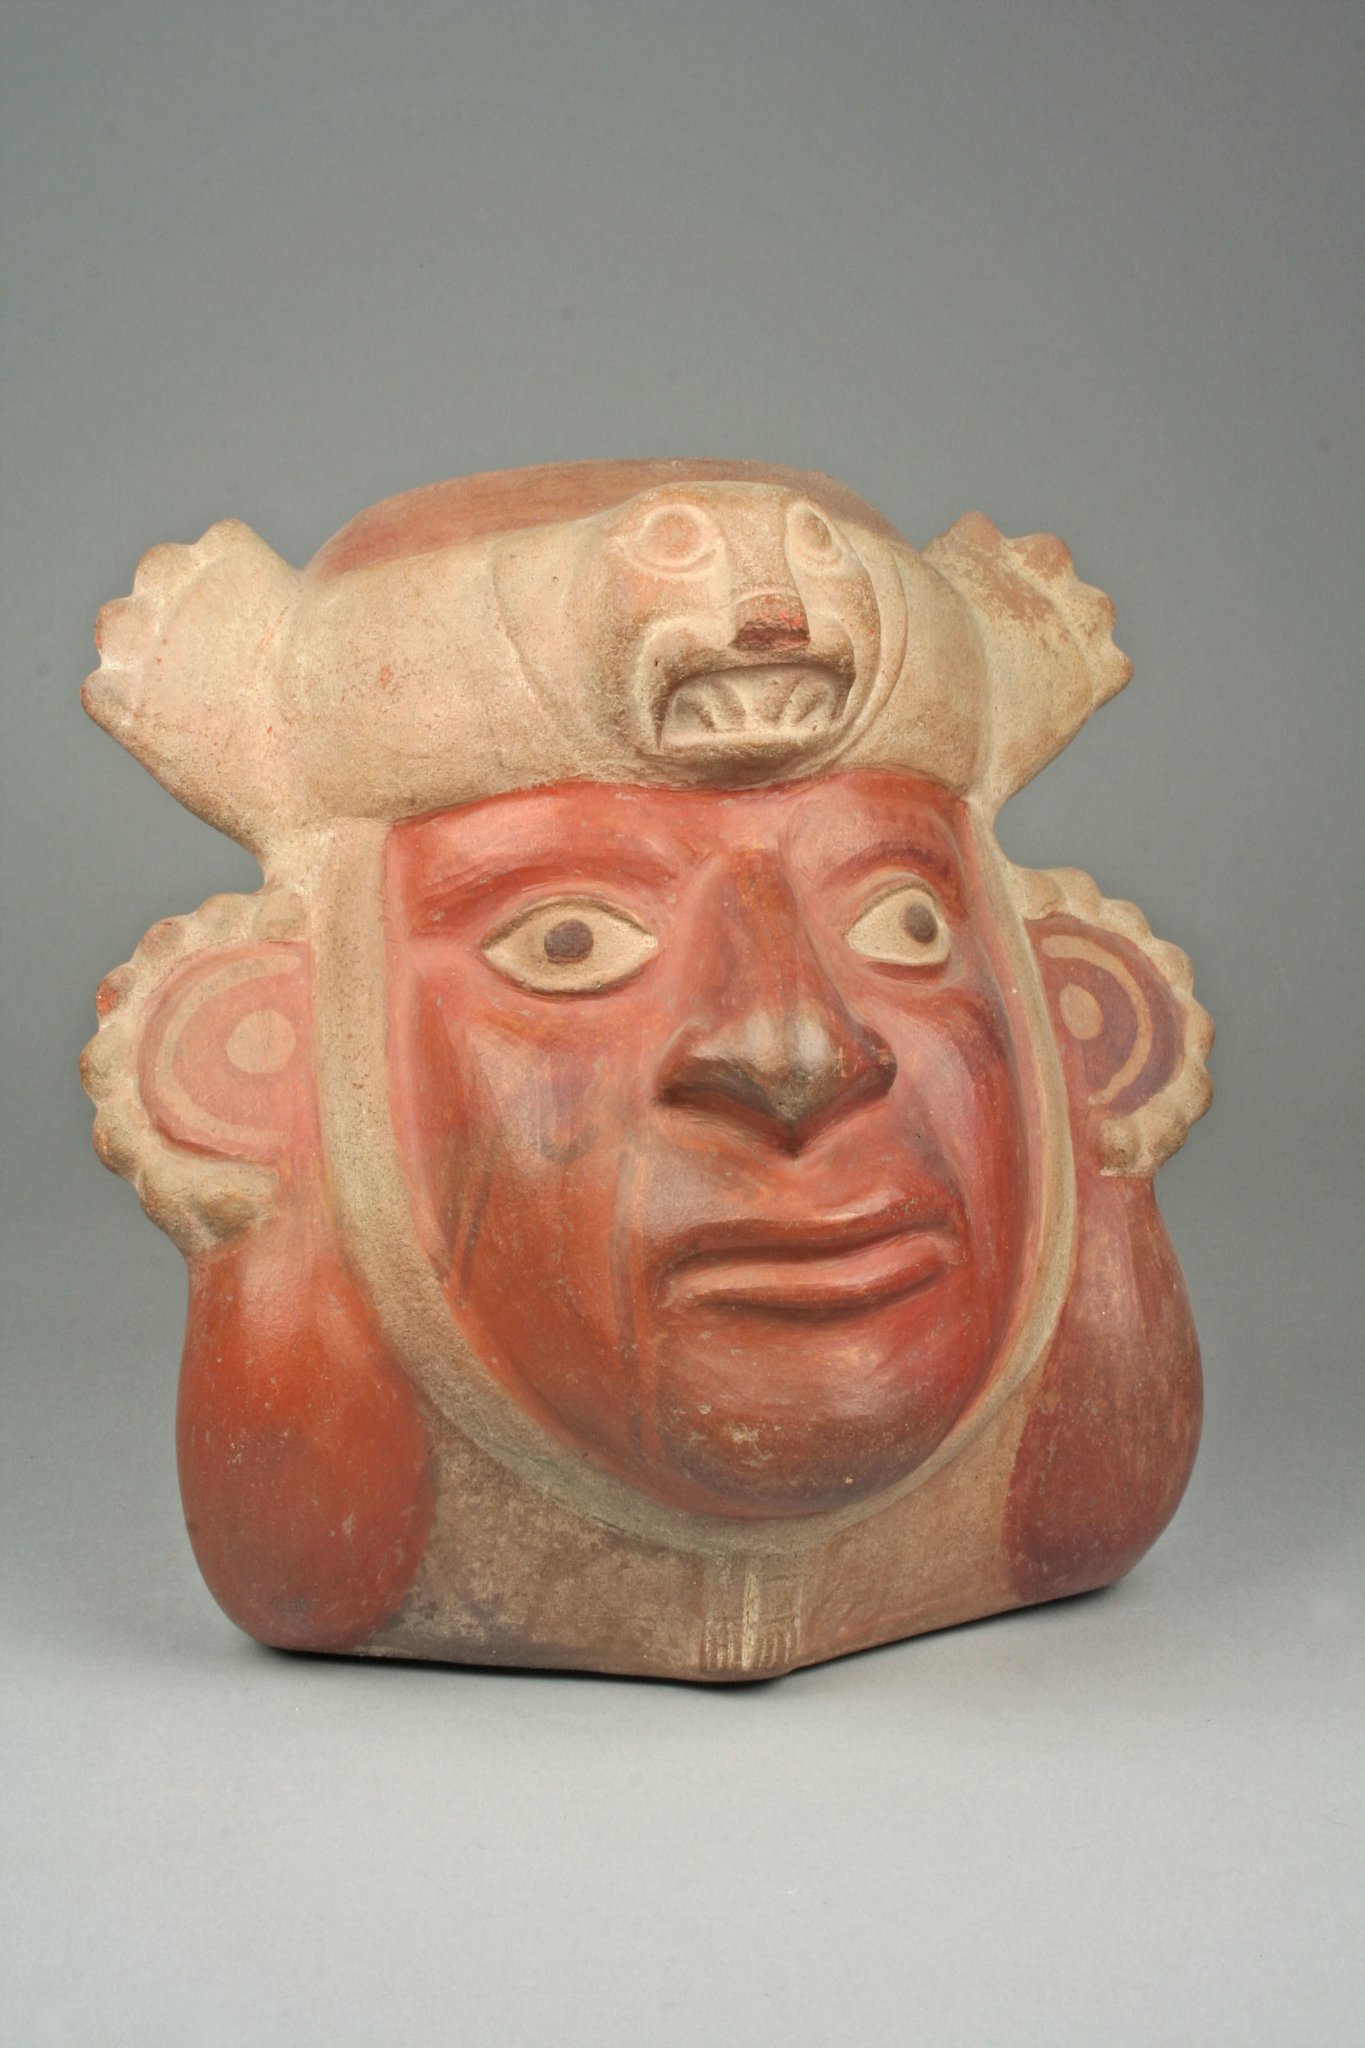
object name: bottle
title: Stirrup Spout Bottle with Portrait Head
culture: moche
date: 201-500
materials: ceramic, pigment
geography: peru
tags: heads